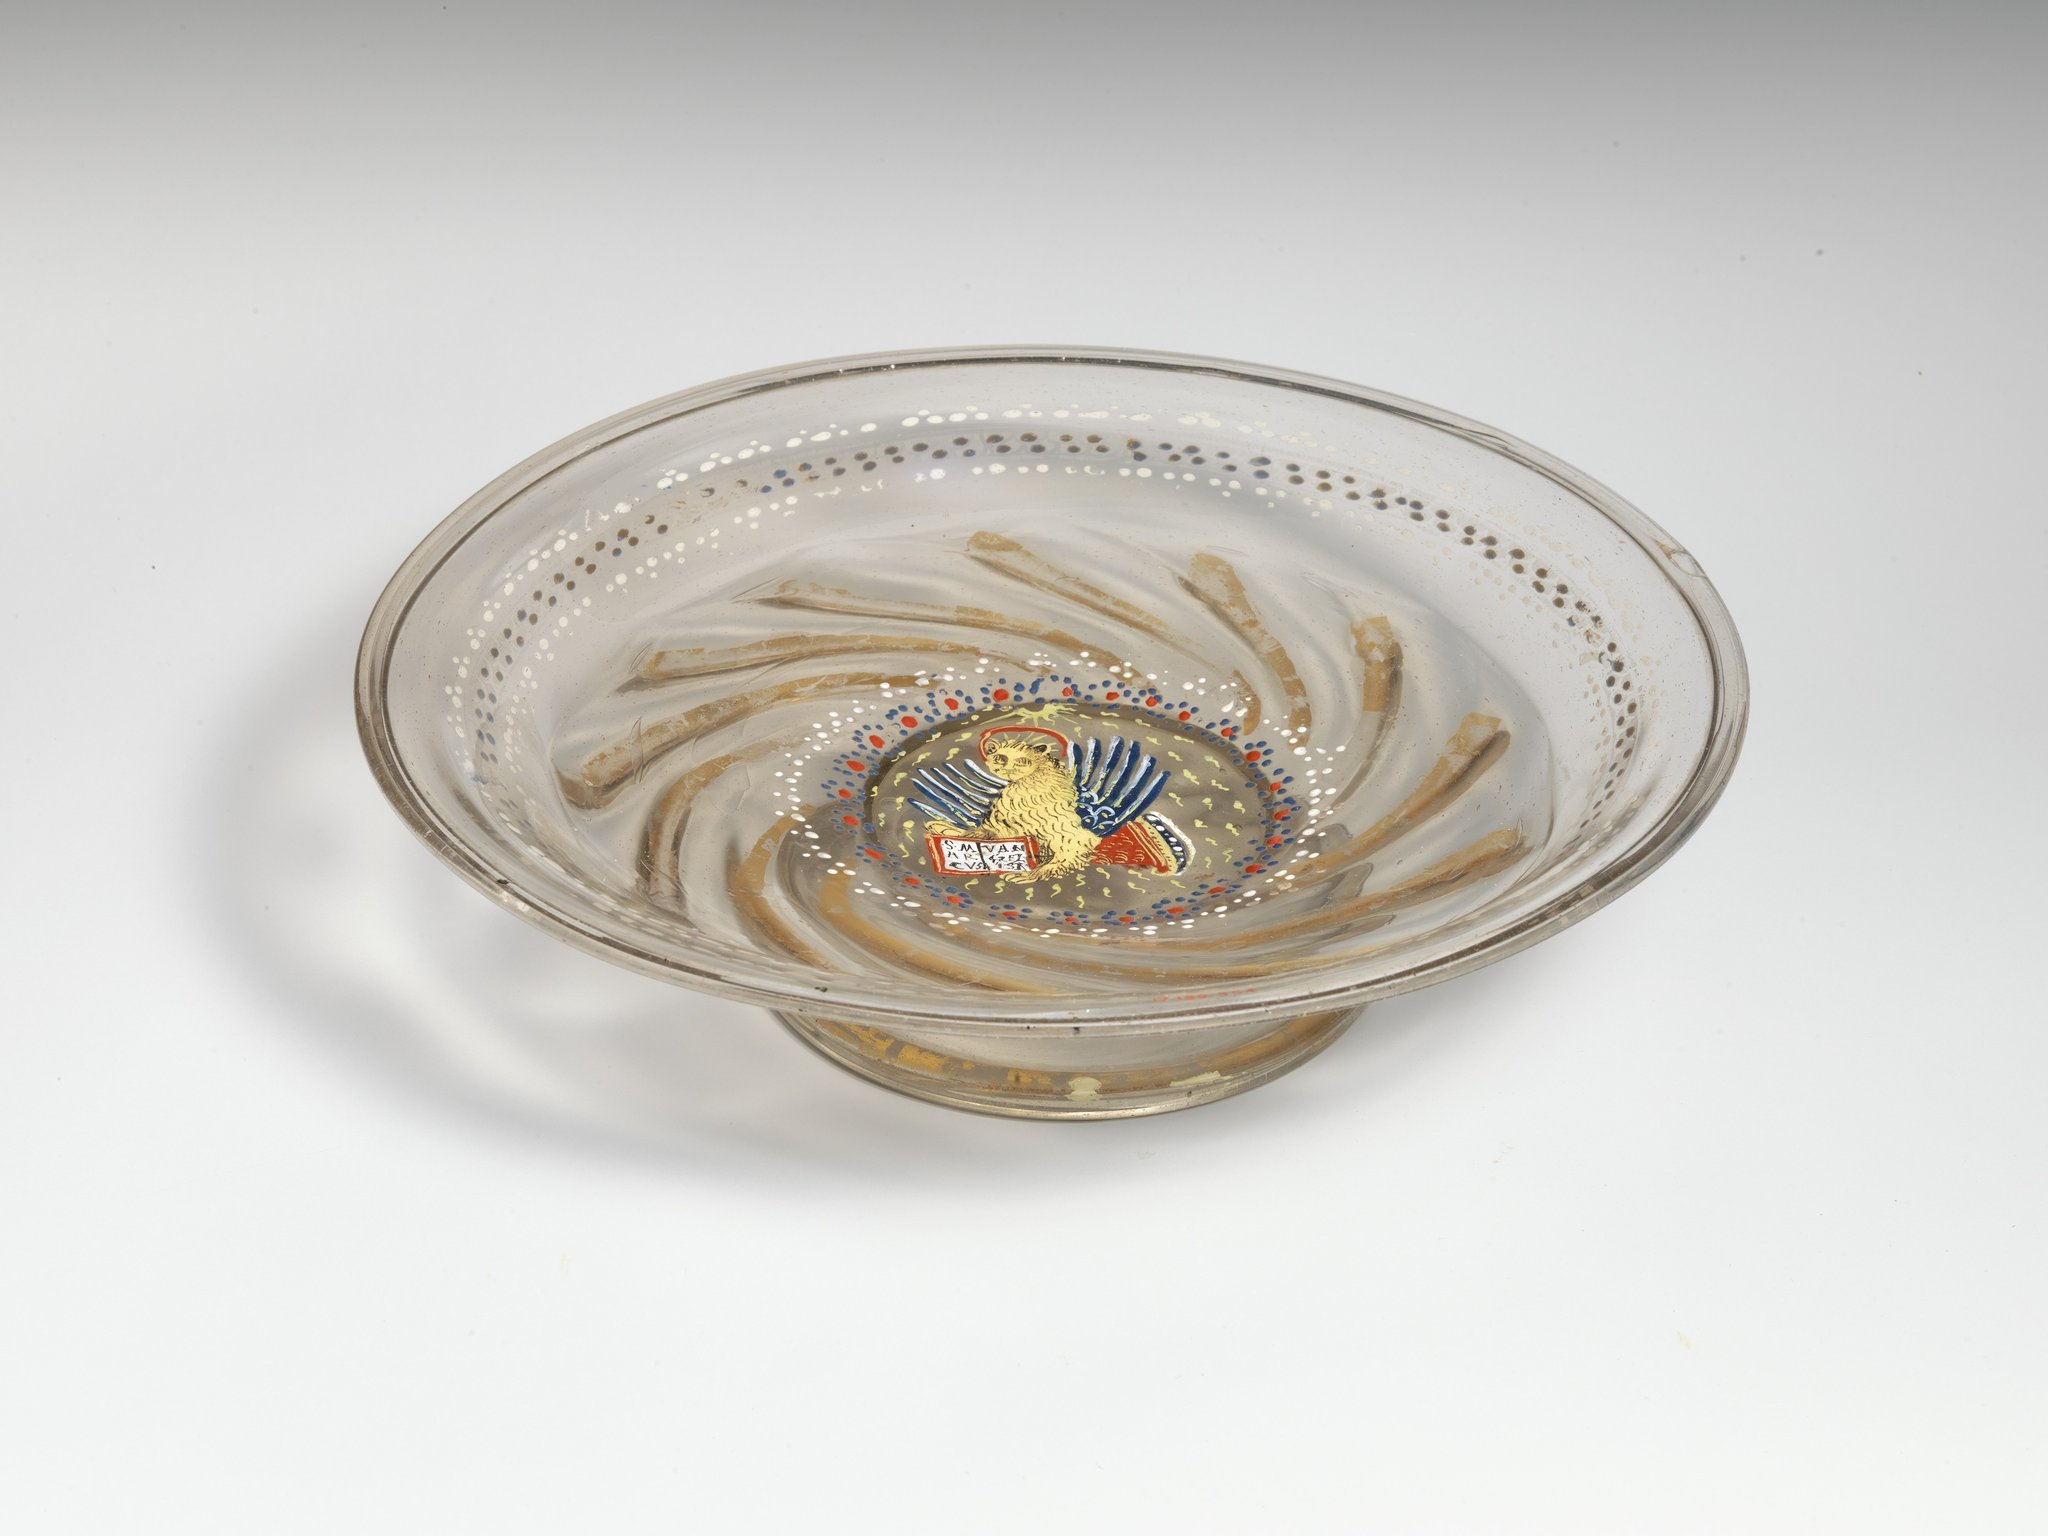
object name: bowl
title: Low footed bowl with central medallion of the winged lion of St. Mark in colored enamels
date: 1501-1550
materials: gilt, glass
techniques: enamel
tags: lions